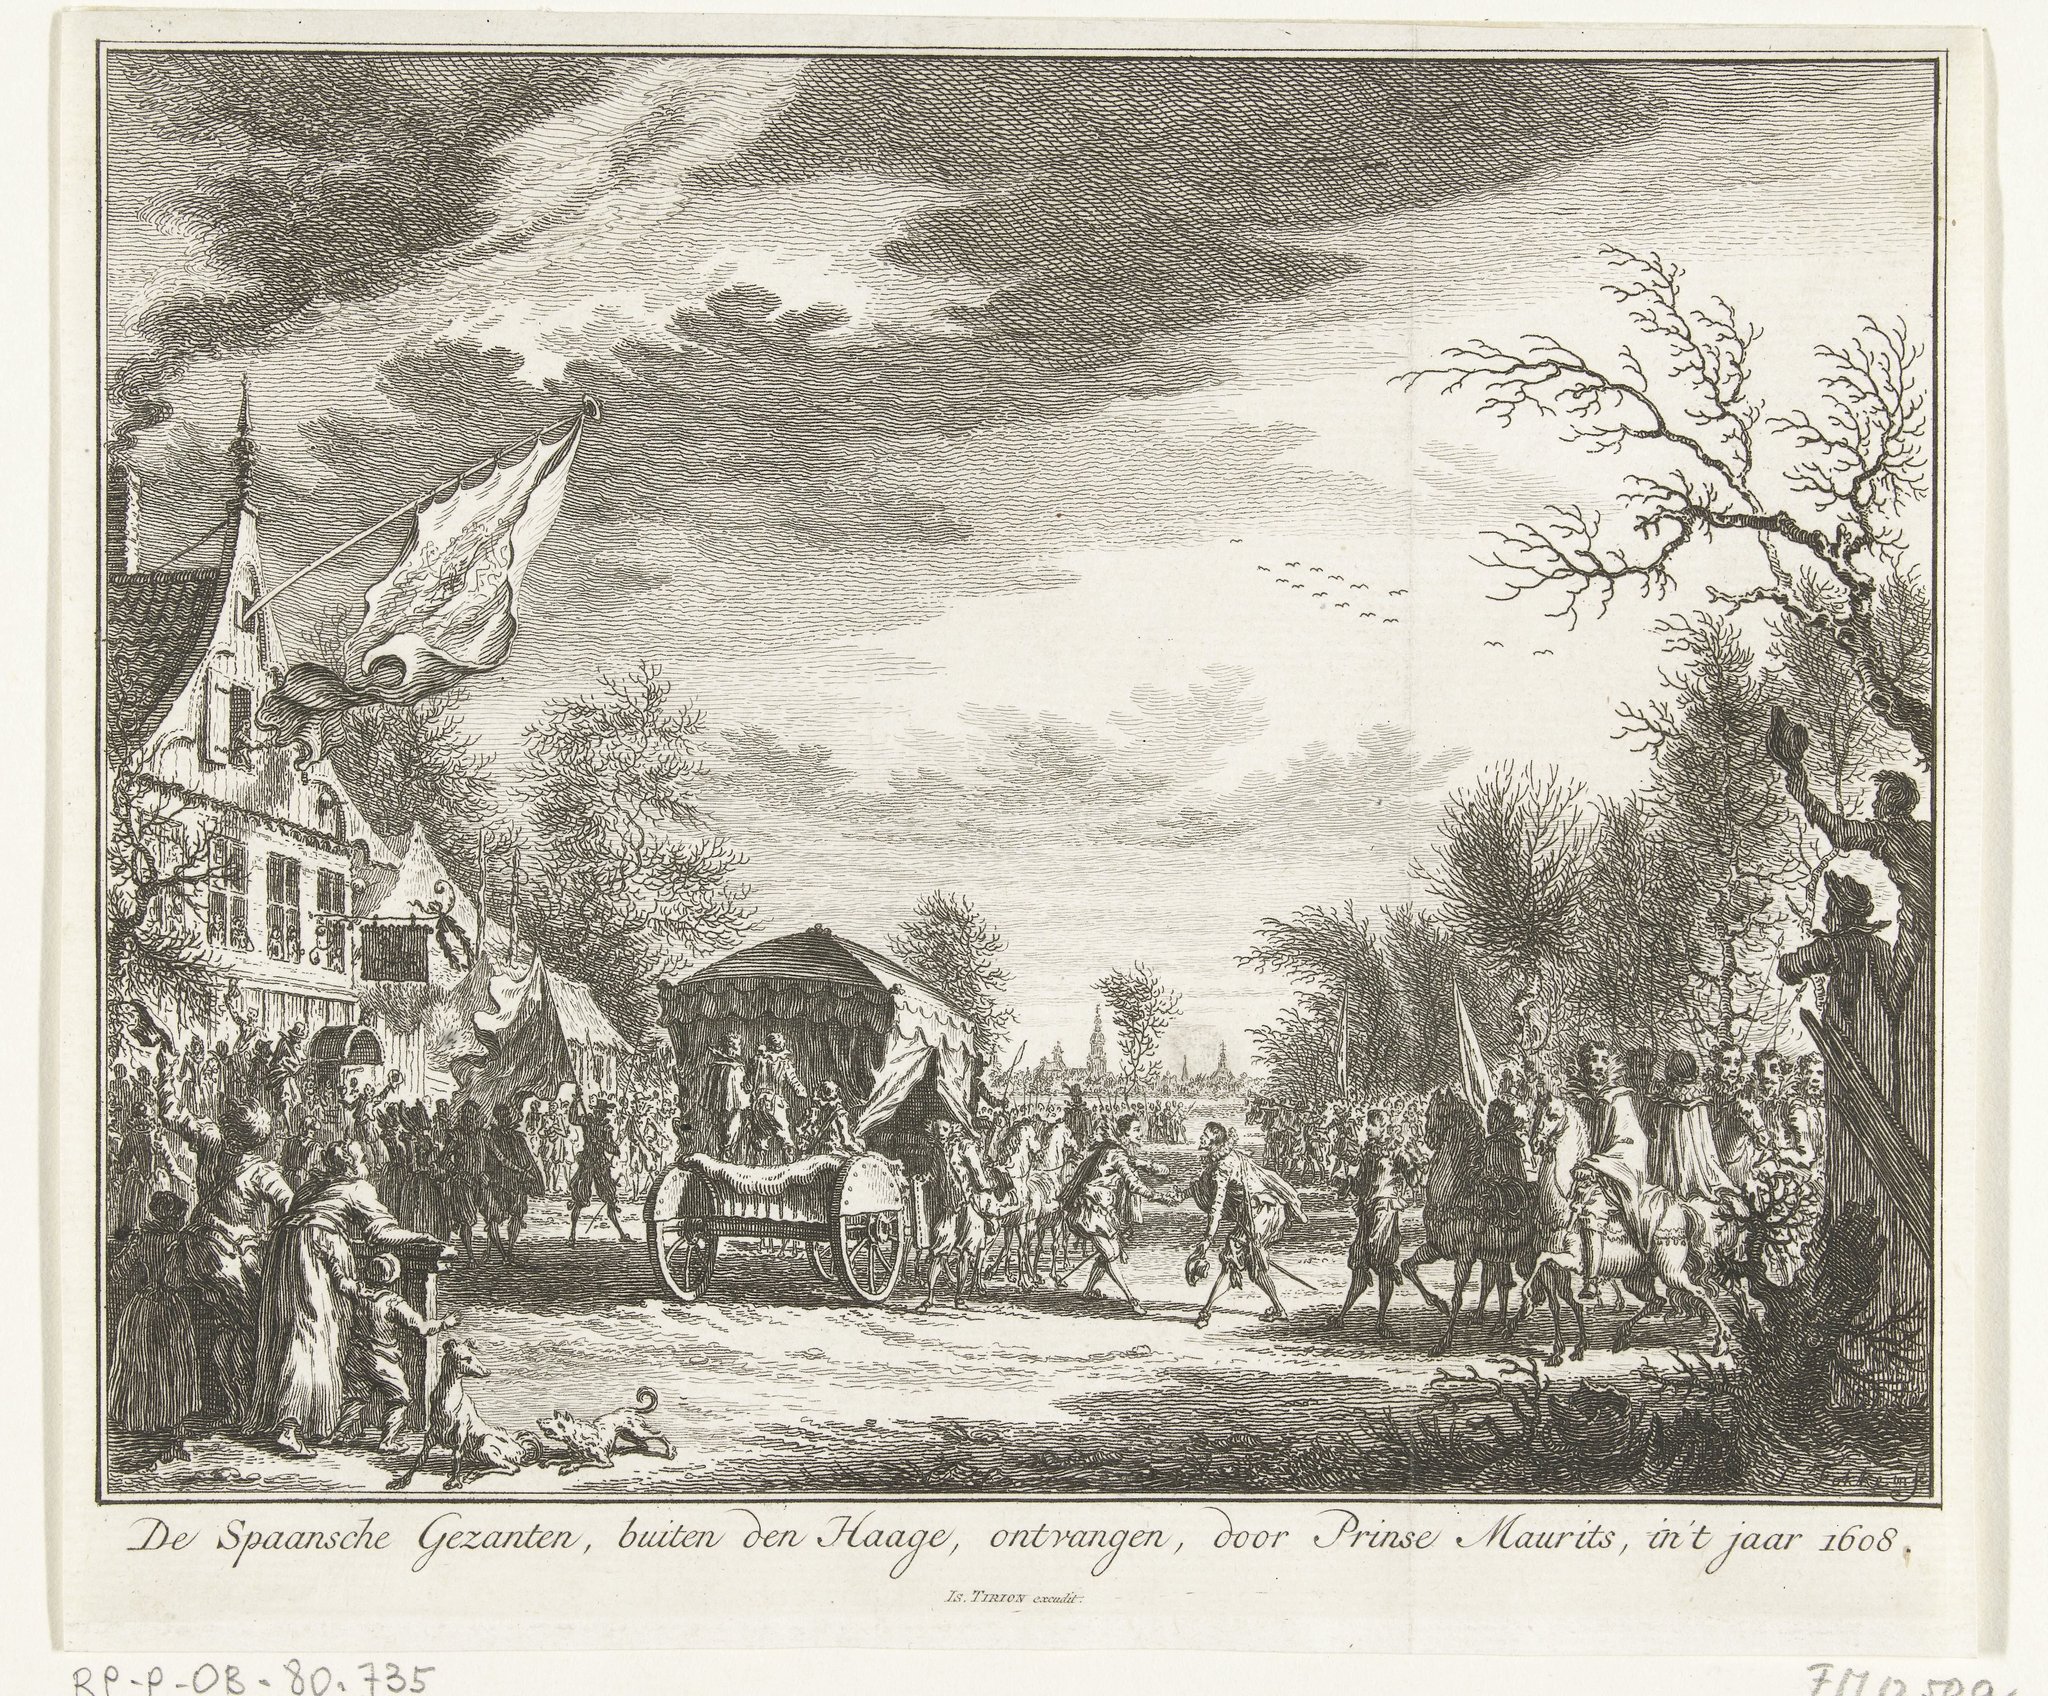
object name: print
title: Aankomst van de Spaanse gezanten te Rijswijk, februari 1608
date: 1747-1759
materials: paper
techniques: etching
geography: northern netherlands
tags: the hague, maurice (prince of orange), peace negotiations, meeting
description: Aankomst en begroeting te Rijswijk van de Spaanse gezanten voor de vredesonderhandelingen, februari 1608. Maurits en Spinola geven elkaar de hand. Het rijtuig is gestopt voor een herberg waar veel toeschouwers staan.